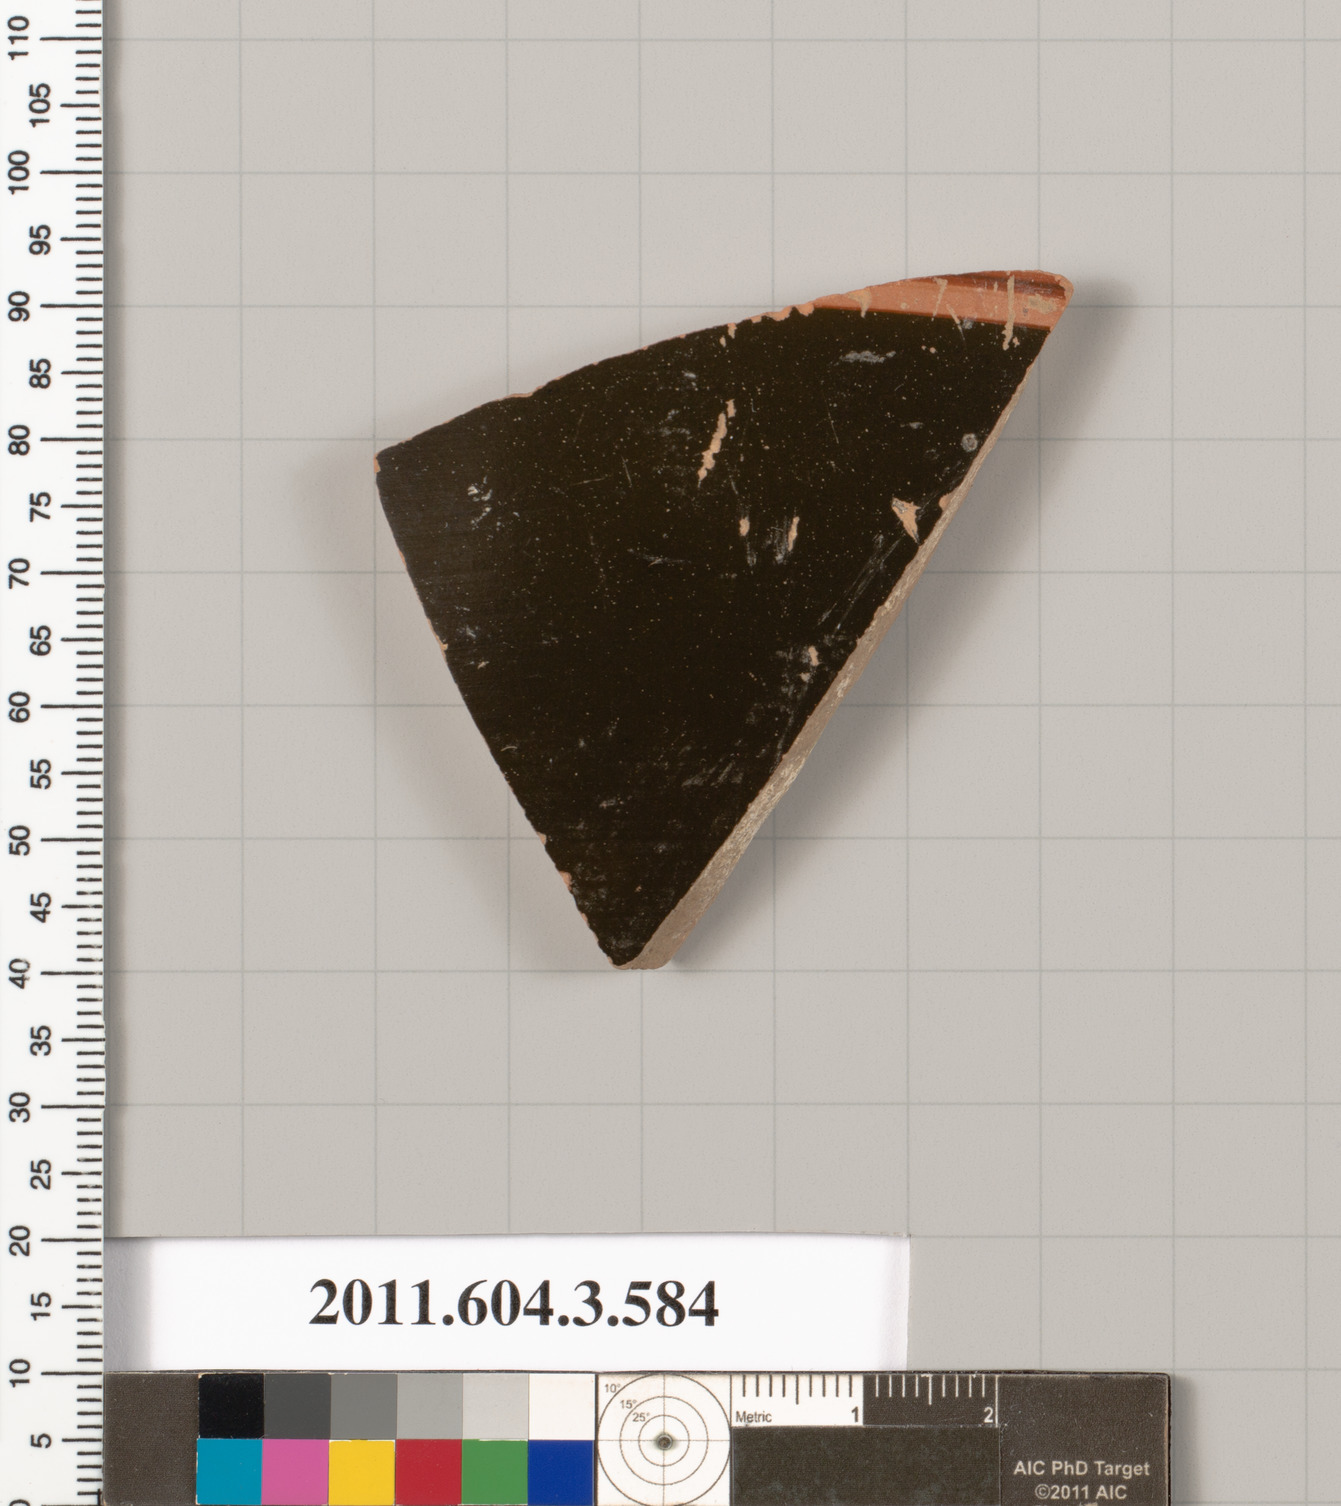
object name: column krater fragment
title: Terracotta fragment of a column-krater (bowl for mixing wine and water)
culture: greek, attic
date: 600-401 BCE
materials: terracotta